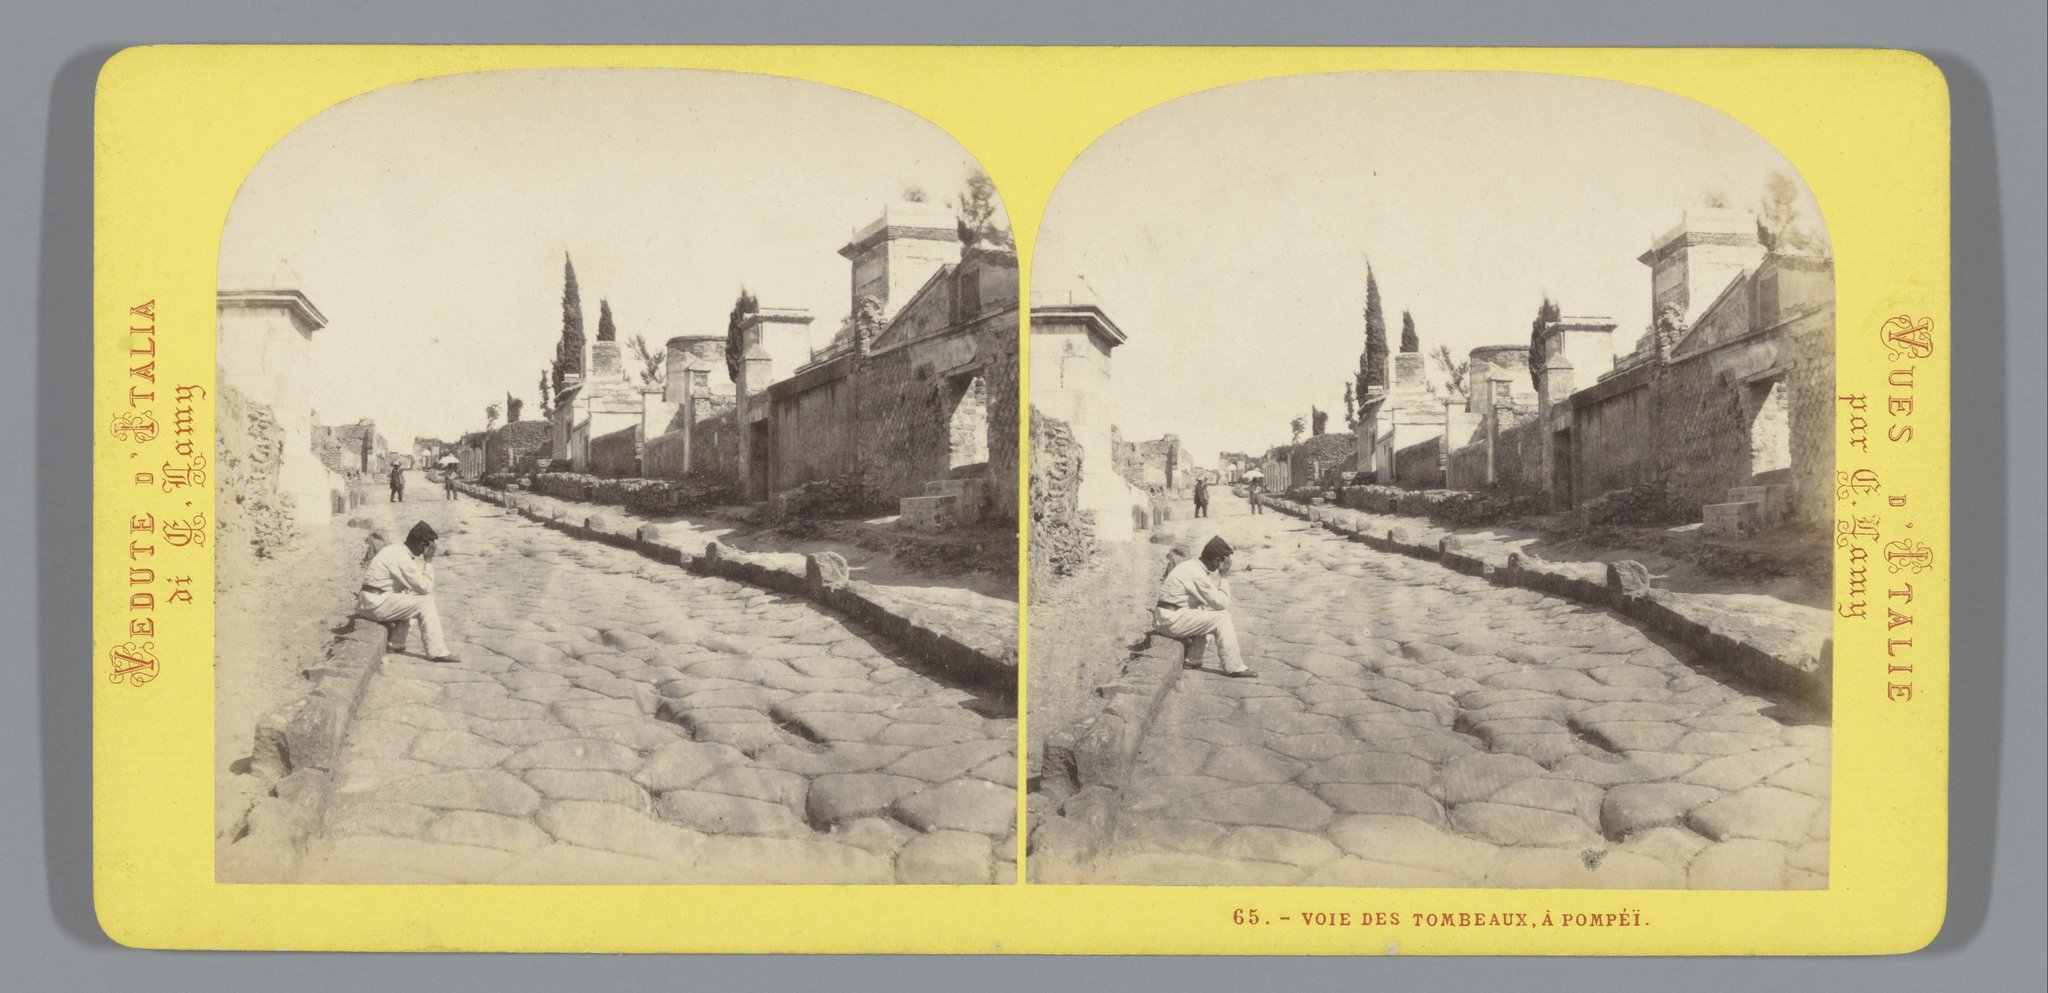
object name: stereograph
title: Via delle Tombe (de Weg van de Tombes) in Pompeï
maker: ernest eléonor pierre lamy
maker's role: publisher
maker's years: 1828-1900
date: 1861-1878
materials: cardboard, paper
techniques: albumen print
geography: pompeii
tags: necropolis, grave, tomb, pompeii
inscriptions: number: ‘65.’